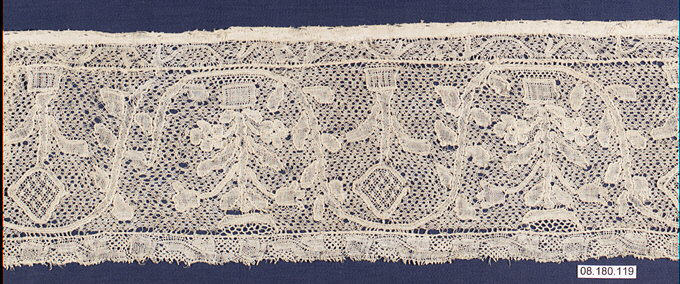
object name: fragment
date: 1667-1700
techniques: lace